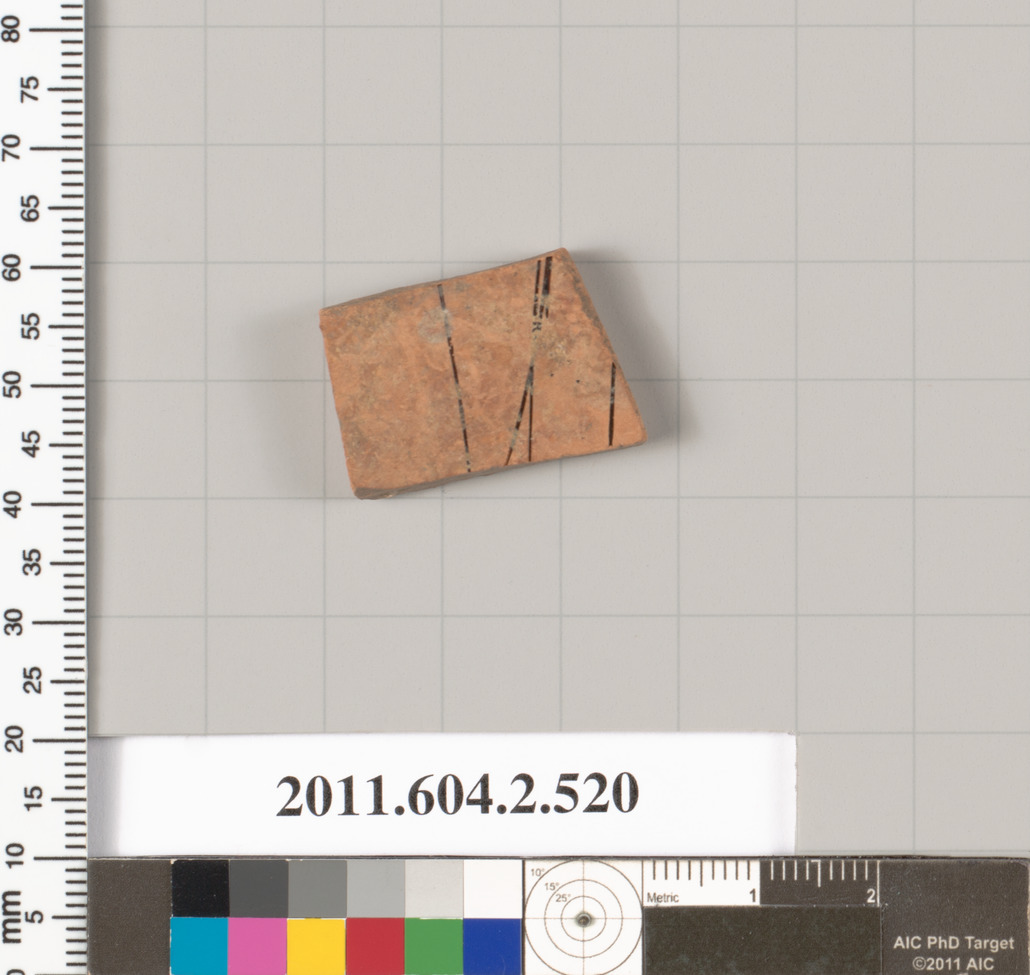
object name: column krater fragment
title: Terracotta fragment of a column-krater (bowl for mixing wine and water)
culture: greek, attic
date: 460-440 BCE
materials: terracotta